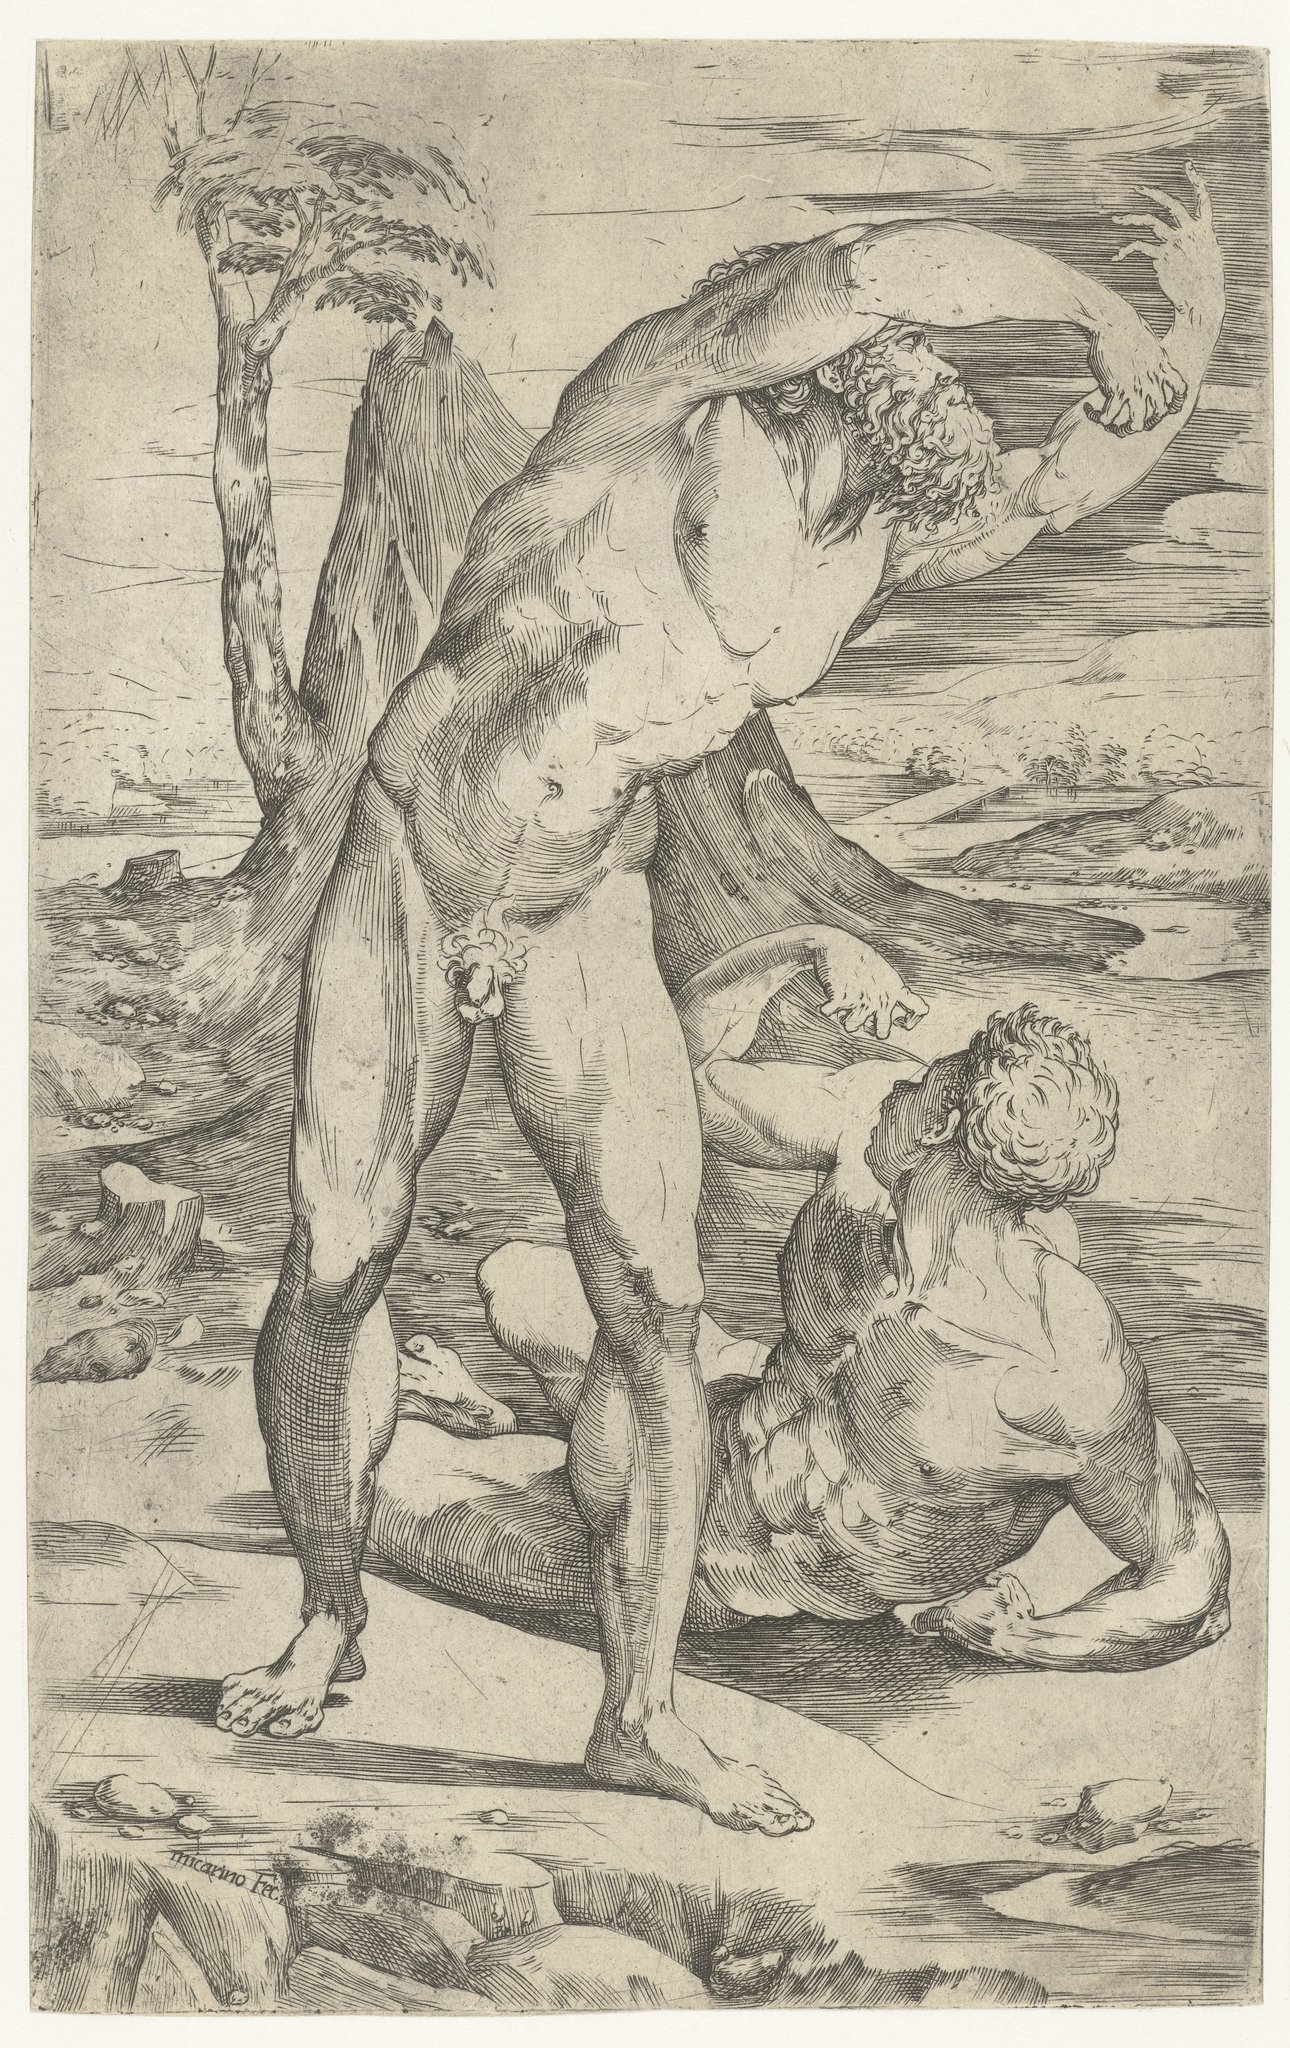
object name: print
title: Twee naakte mannen in een landschap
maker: domenico beccafumi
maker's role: draughtsman, painter, print maker, sculptor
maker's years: 1486-1551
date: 1535-1540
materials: paper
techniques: engraving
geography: italy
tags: the (nude) human figure; 'corpo humano' (ripa), male sex; man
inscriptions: collector's mark: Lugt 2228, collector's mark: Lugt 2760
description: Een voorstudie bevindt zich in Chatsworth.